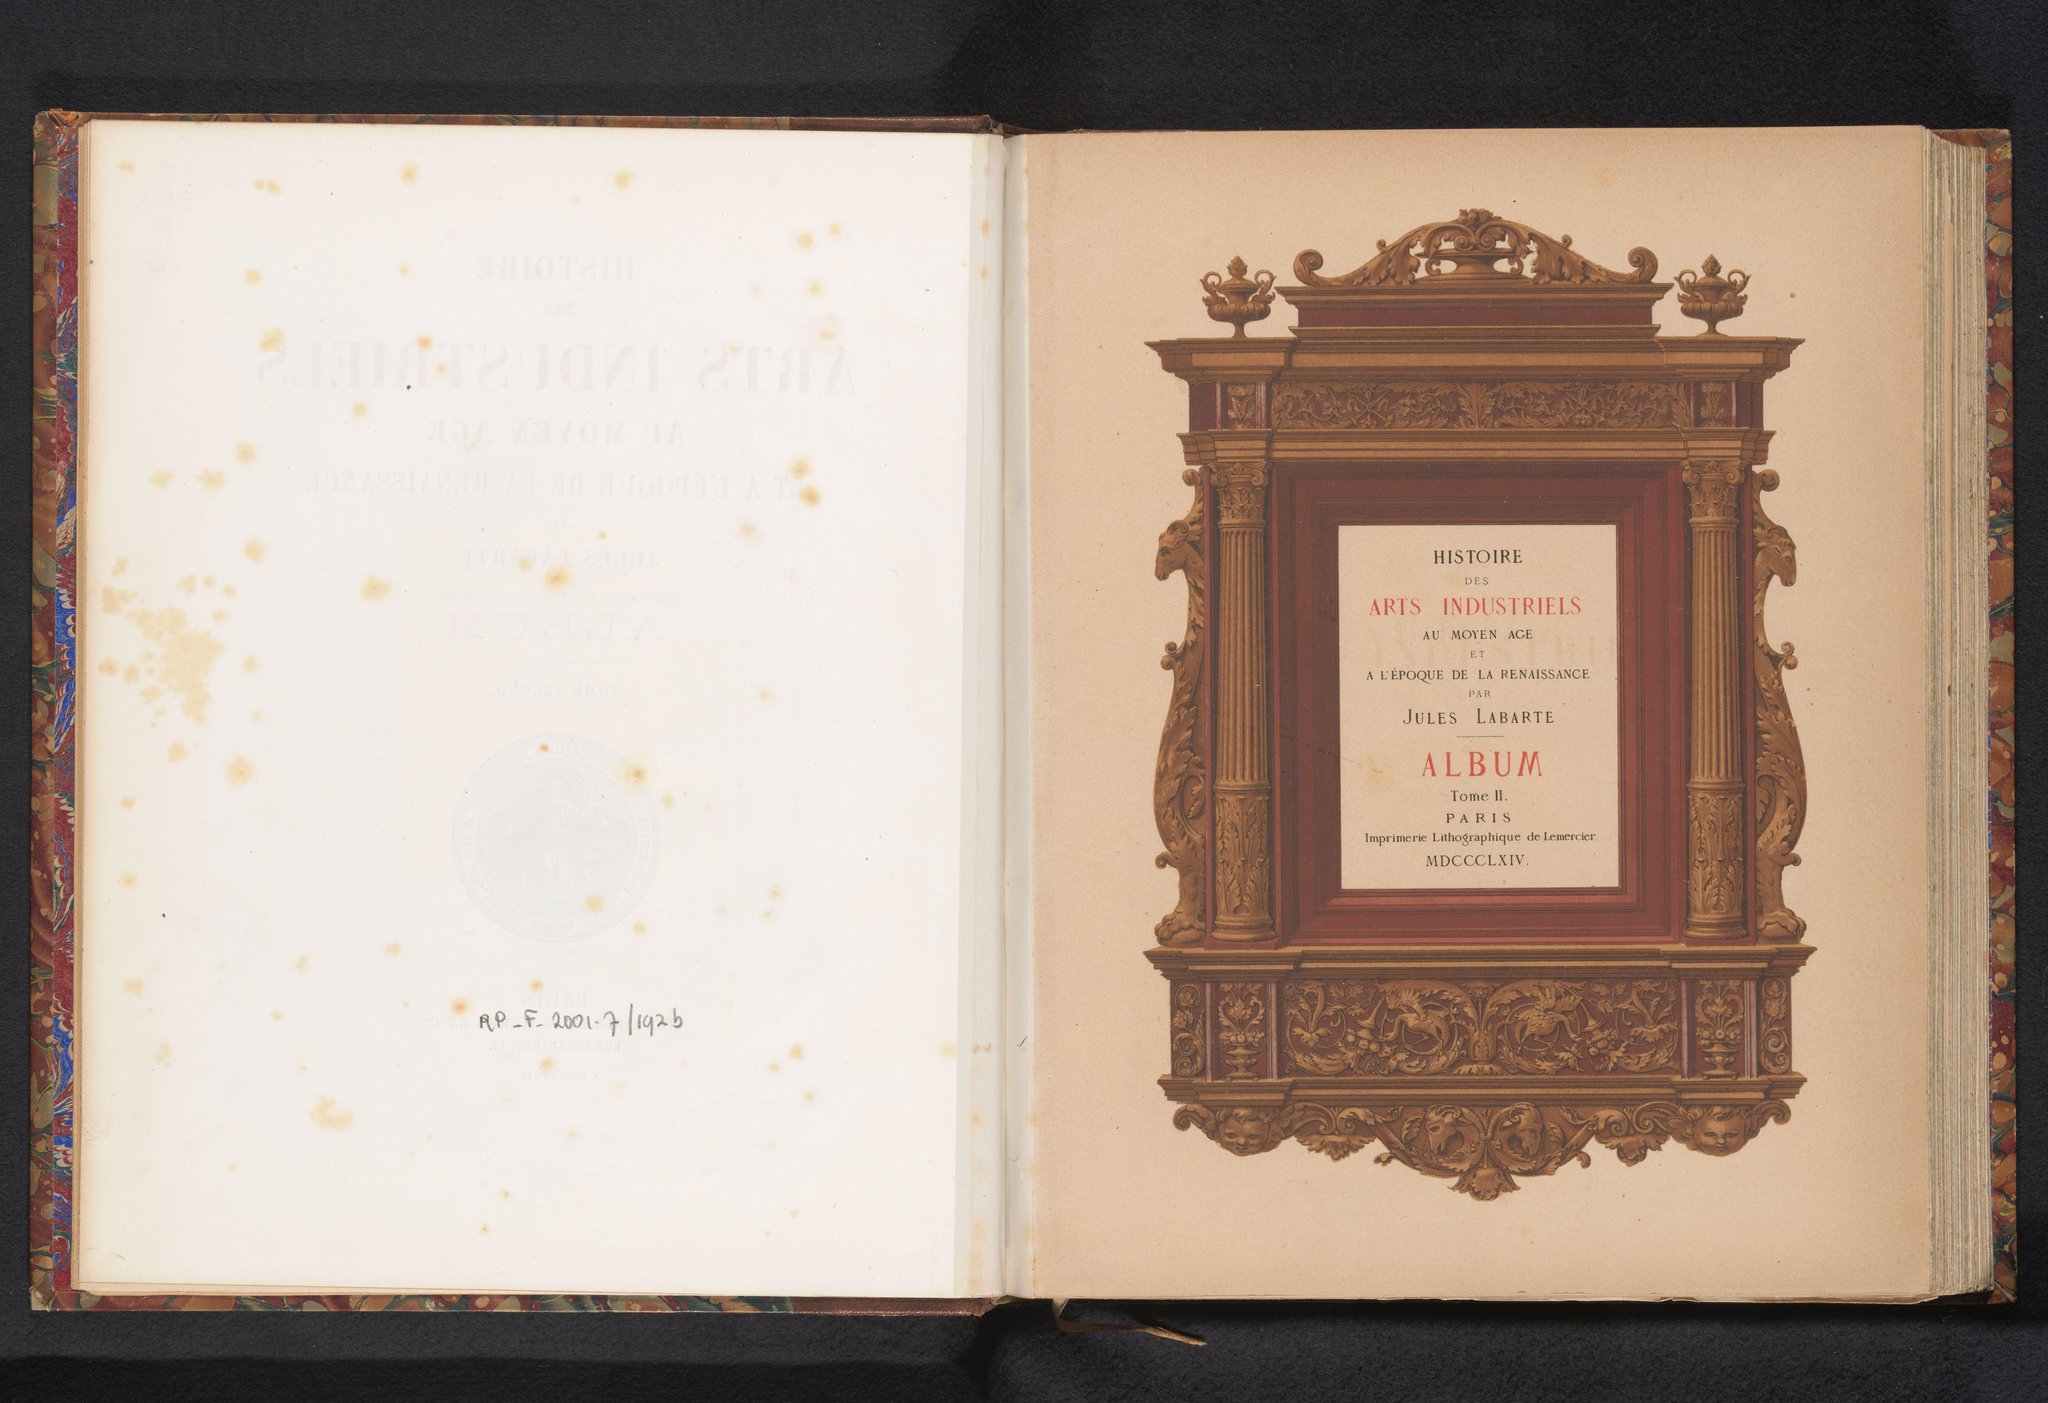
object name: page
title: Titelpagina met omlijsting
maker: Anonymous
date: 1859-1864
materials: paper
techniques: chromolithography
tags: title-page